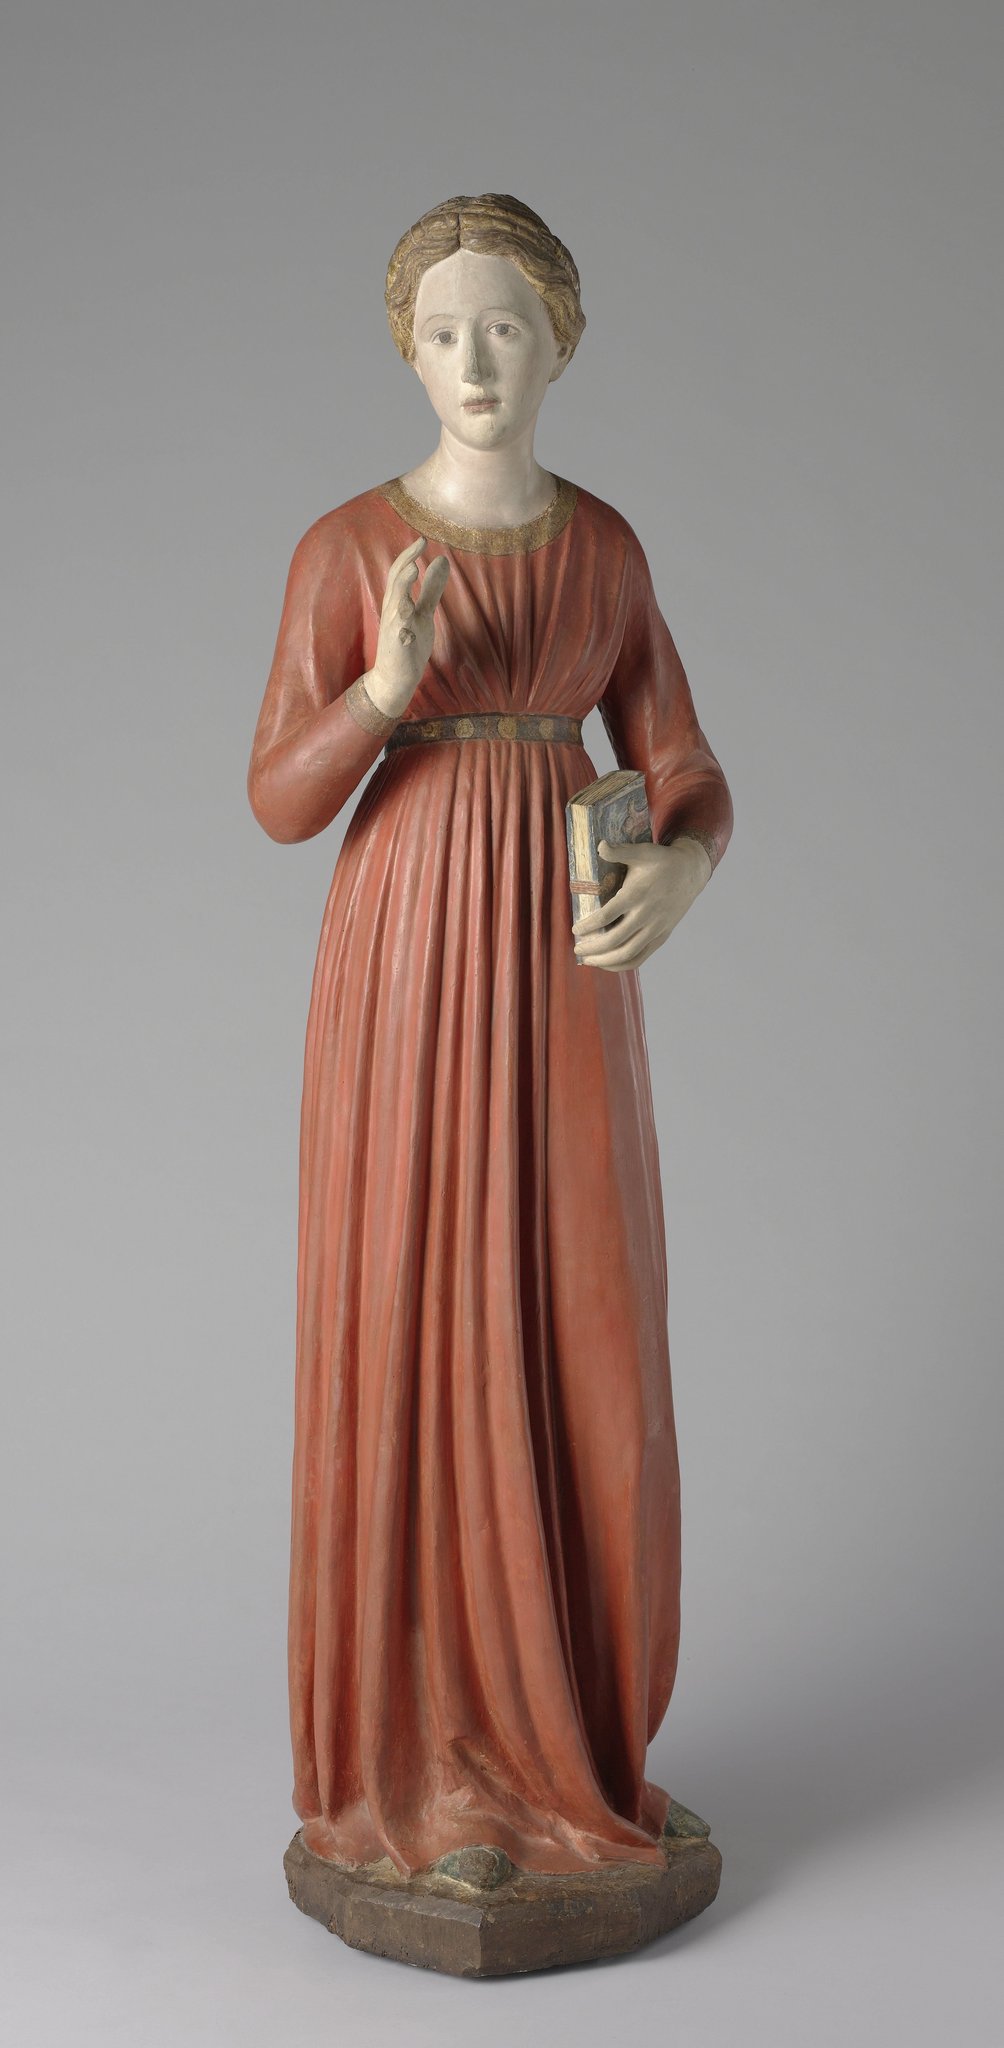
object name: sculpture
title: The Annunciation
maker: francesco di valdambrino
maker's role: sculptor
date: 1423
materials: linen, wood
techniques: gilding, polychromy, punching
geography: siena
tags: the annunciation: mary standing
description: The angel Gabriel is telling the Virgin that she will conceive a child. The figures’ slim proportions and long drapery folds typify the so-called ‘International Gothic’, an elegant style that flourished during the transition from the Middle Ages to the Renaissance. This figure group was made to flank the high altar of the church of San Francesco in Pienza (Tuscany).